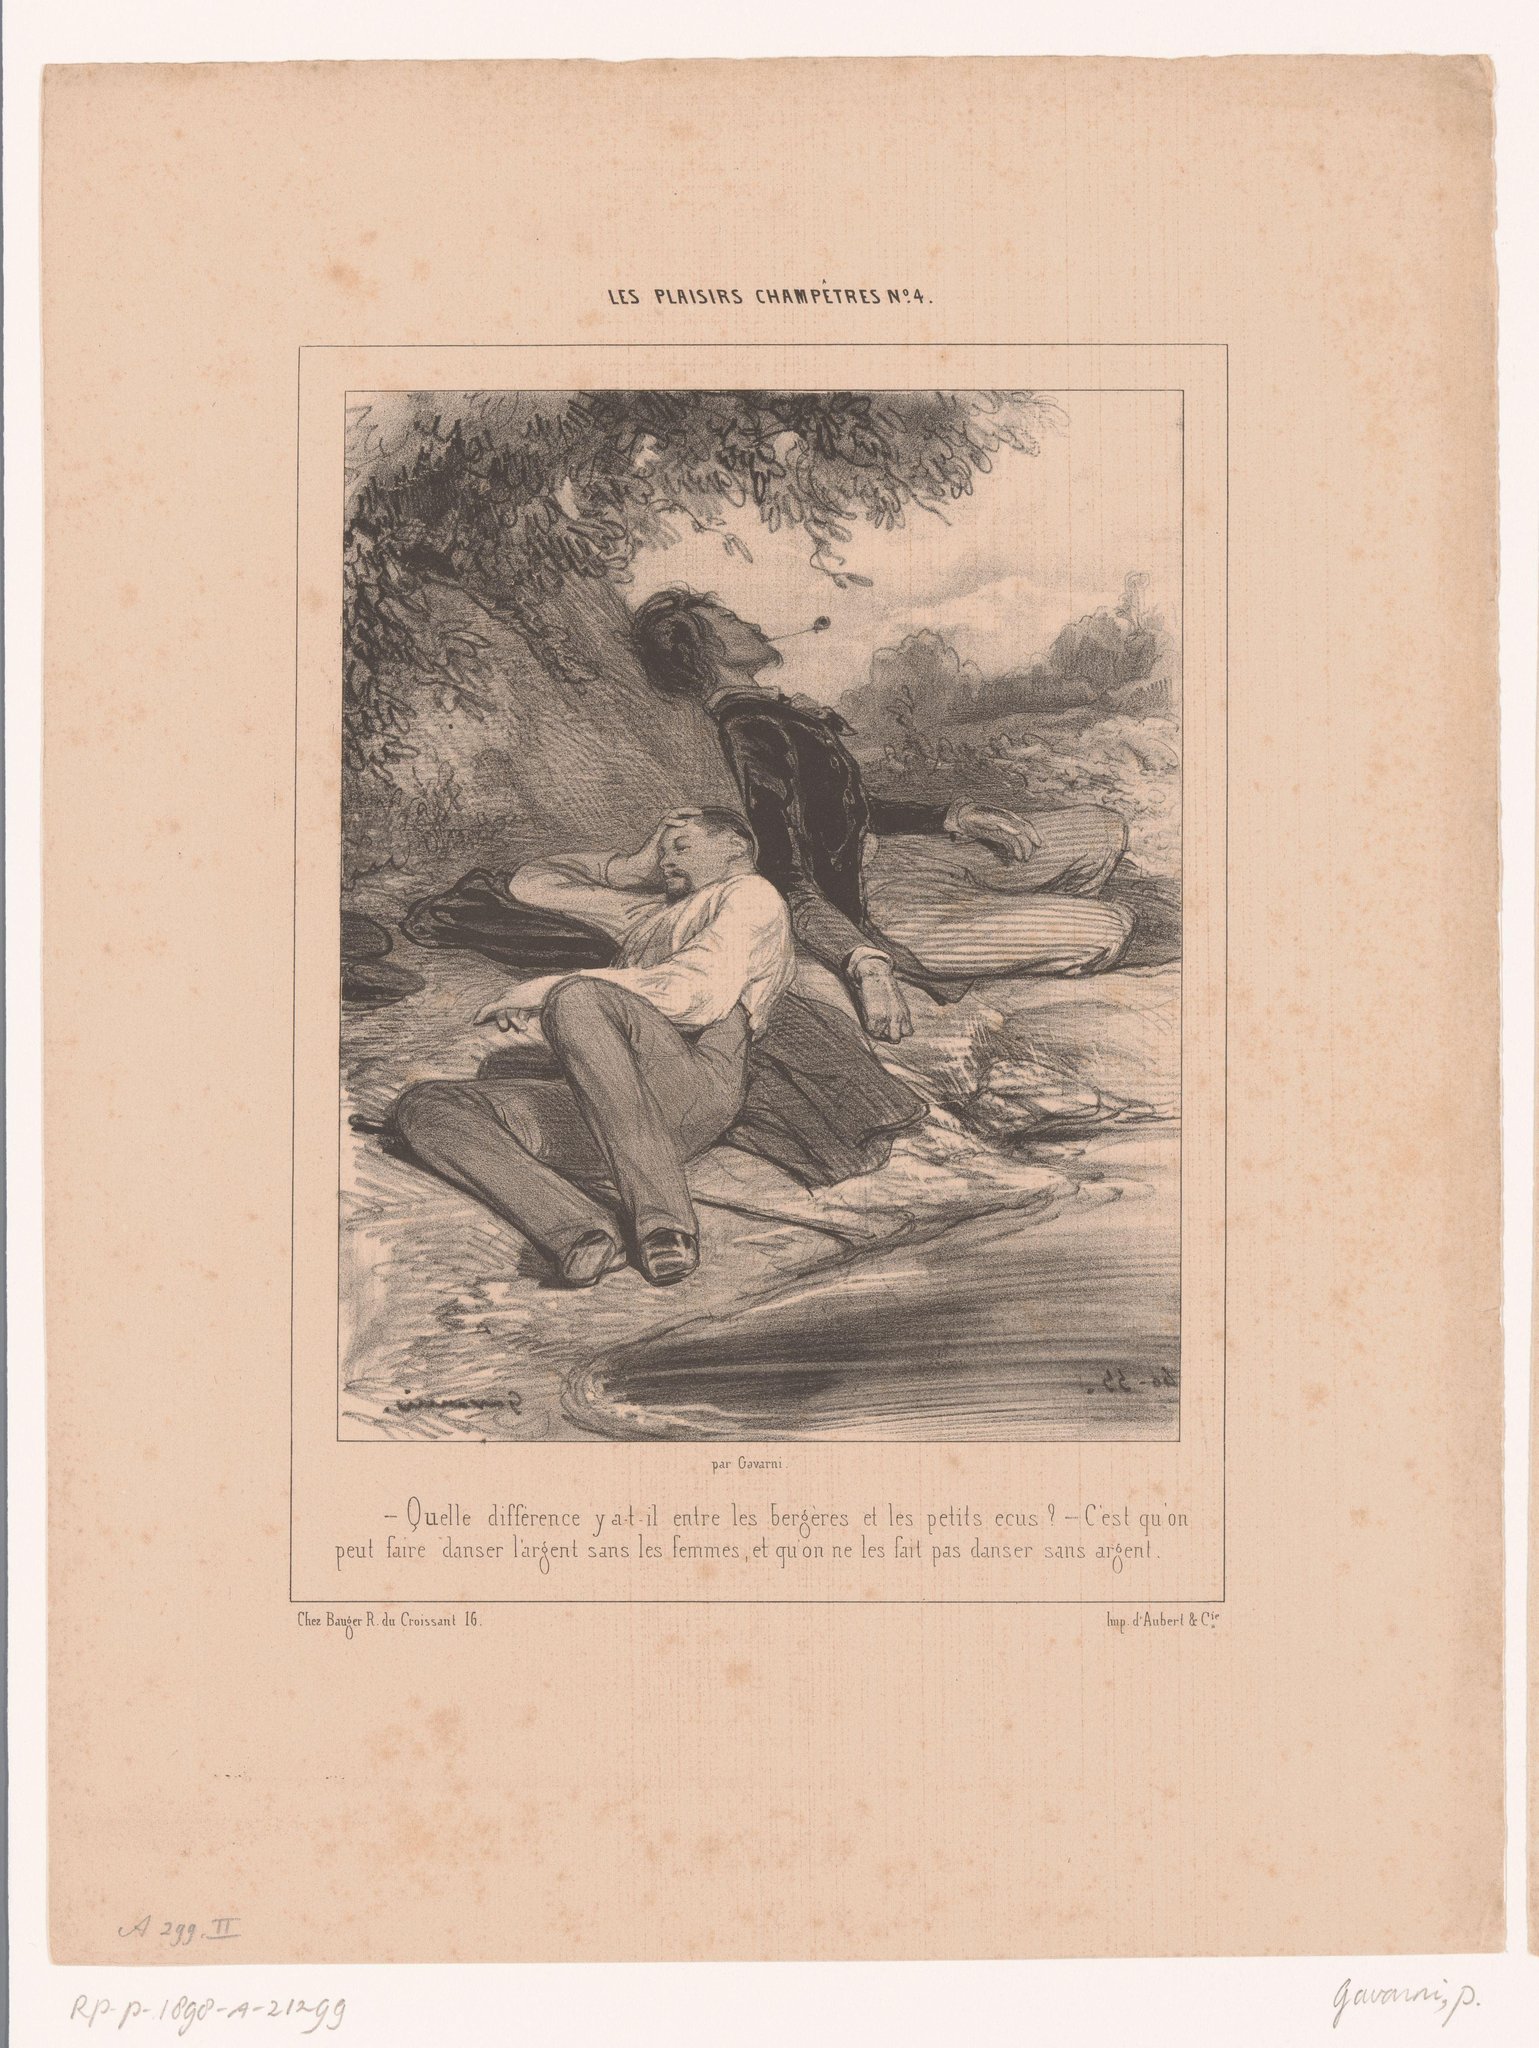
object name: cartoon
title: Quelle différence y a-t-il entre les bergères et les petits écus? (...)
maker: paul gavarni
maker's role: draughtsman, print maker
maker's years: 1804-1866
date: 1840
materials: paper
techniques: lithograph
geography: paris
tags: enjoying nature, trees, resting - bb - out of doors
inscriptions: collector's mark: Lugt 964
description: Prent gebruikt voor: La Caricature, 16 augustus 1840.